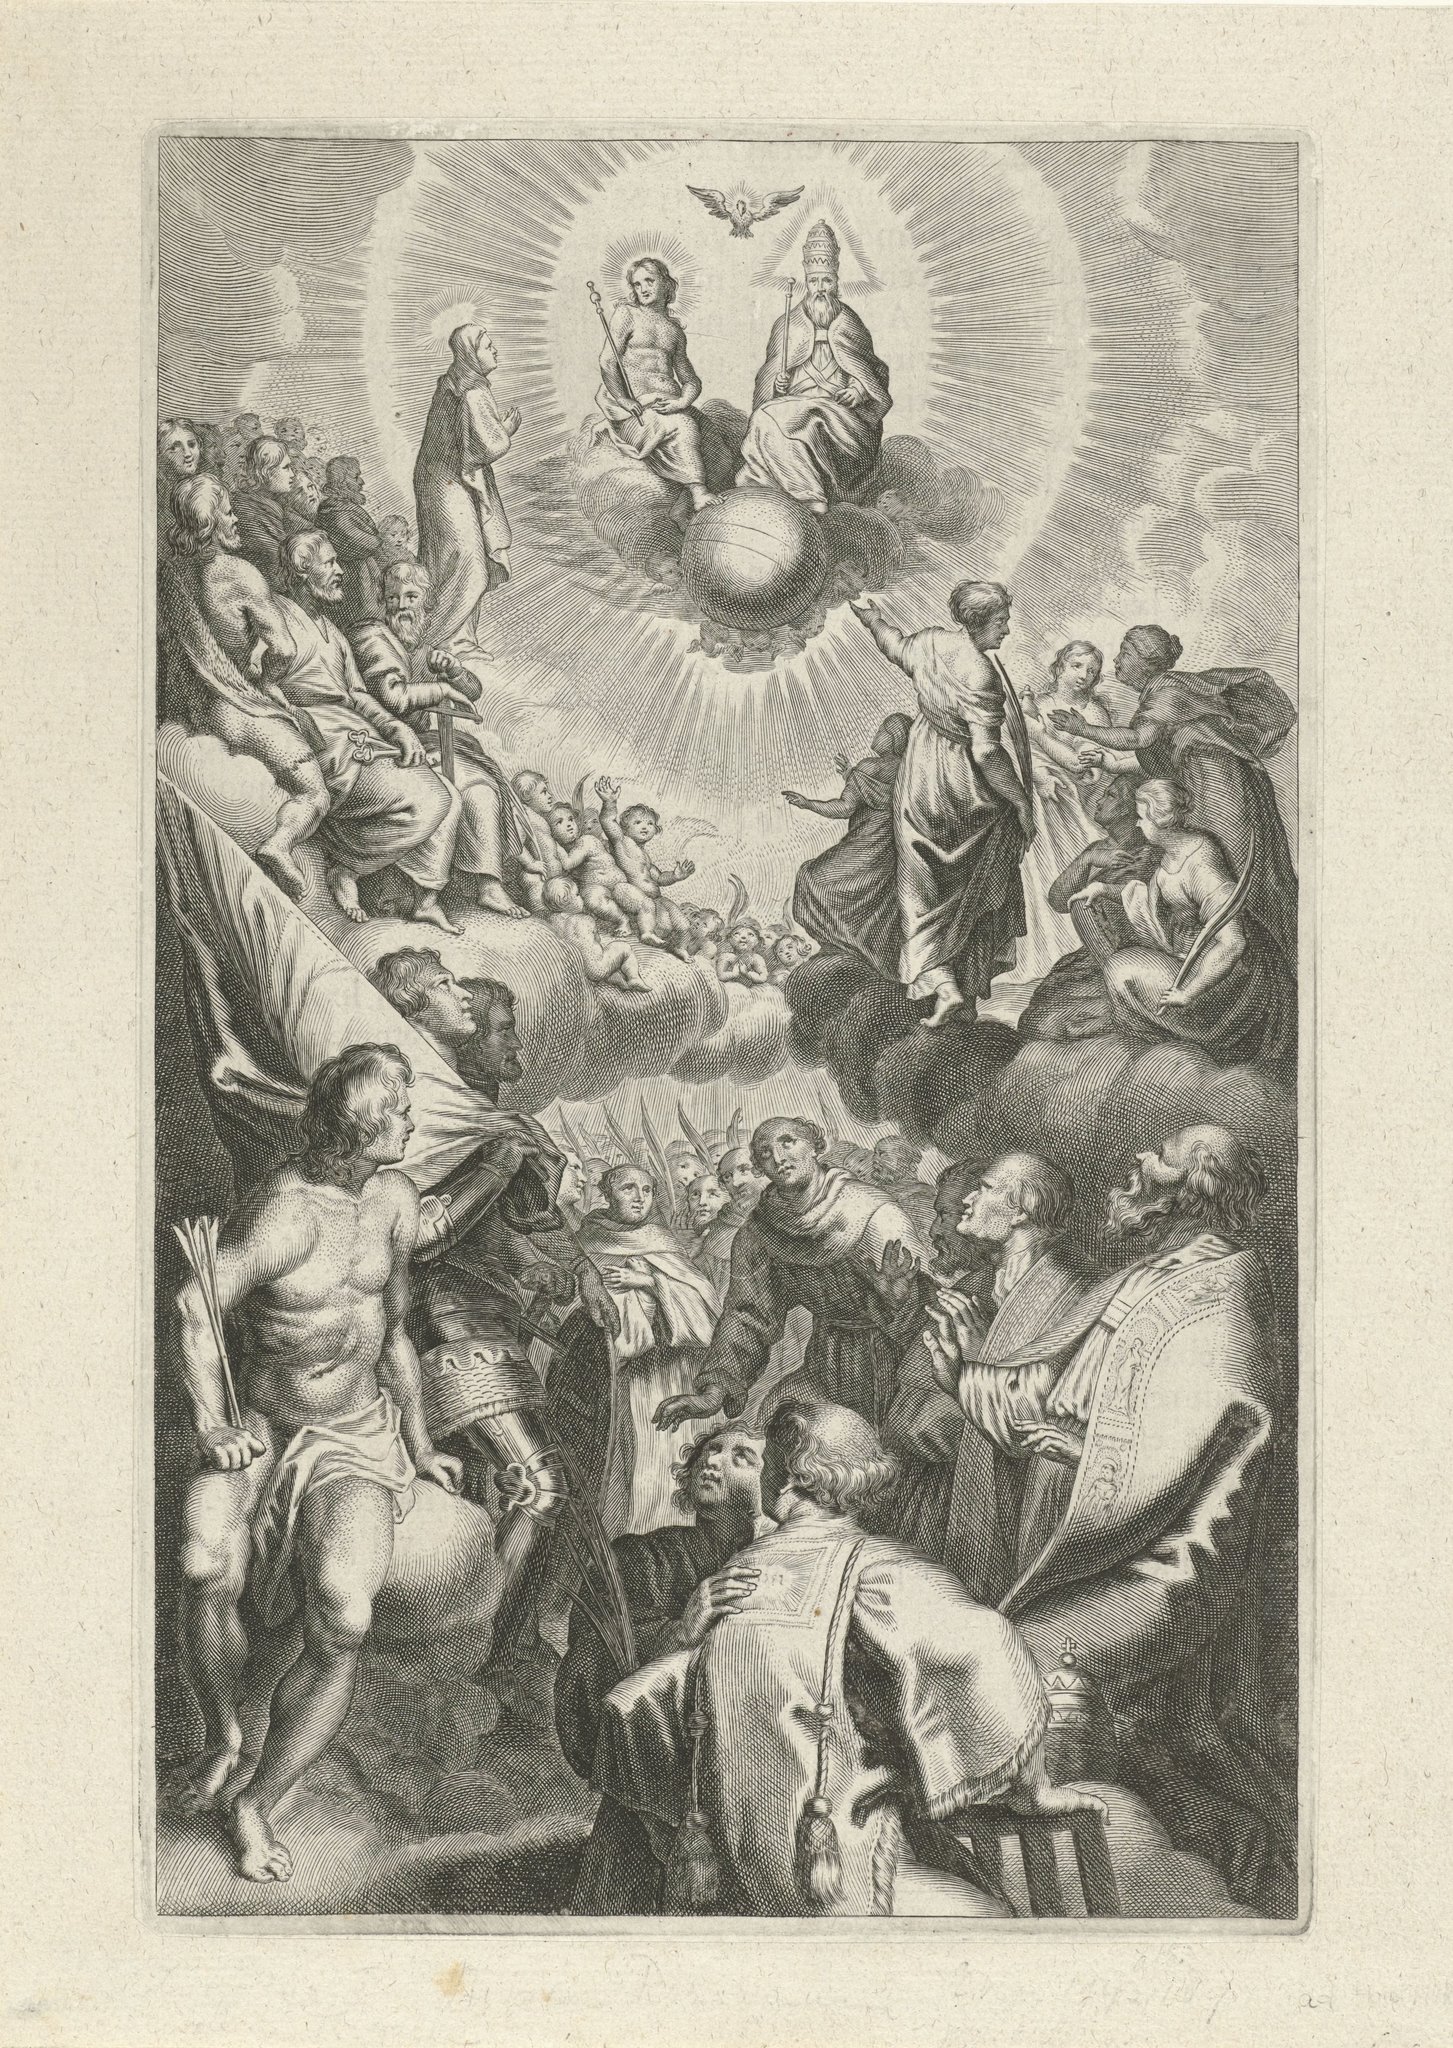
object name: print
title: Allerheiligenvoorstelling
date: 1614-1683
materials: paper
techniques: engraving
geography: antwerp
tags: devotion: all saints picture, 'allerheiligenbild'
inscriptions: collector's mark: Lugt 240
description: Rondom de tronende Drieëenheid van Christus, God en de Heilige Geest zijn alle heiligen verzameld (o.a. de H. Sebastiaan, de H. Joris. de H. Catherina van Constantinopel, etc.). Maria staat naast de Drieëenheid. De prent heeft een Latijns onderschrift.